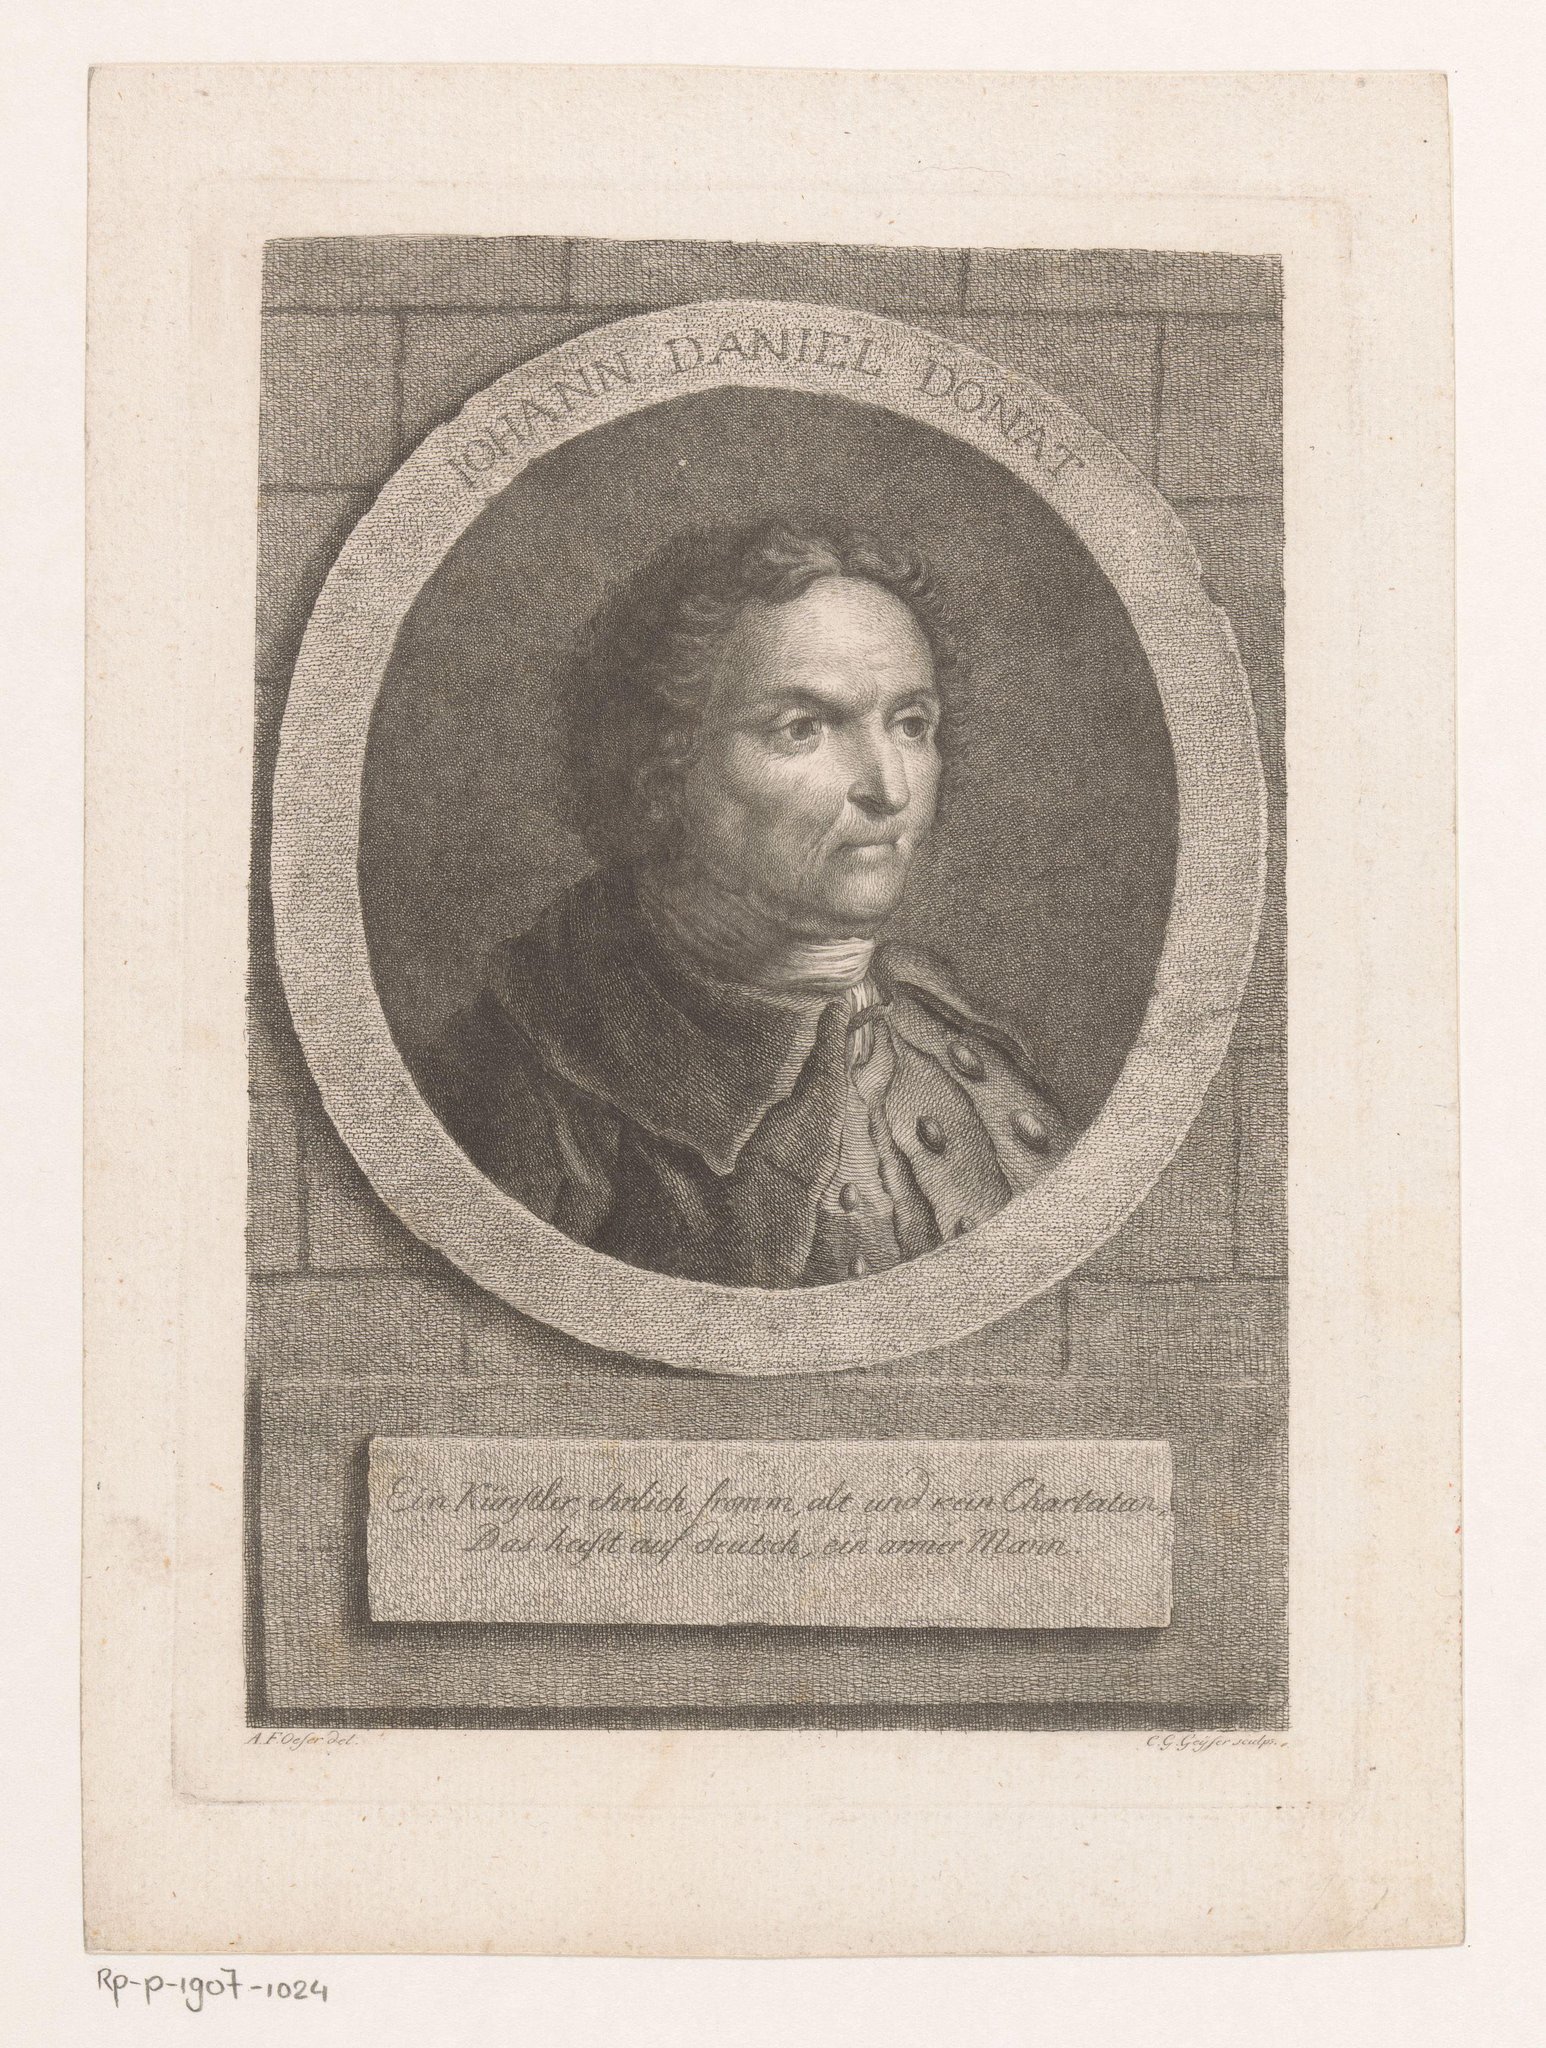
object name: print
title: Portret van Johann Daniel Donat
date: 1754-1803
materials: paper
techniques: etching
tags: historical persons, portrait, self-portrait of painter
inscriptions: collector's mark: Lugt 2228